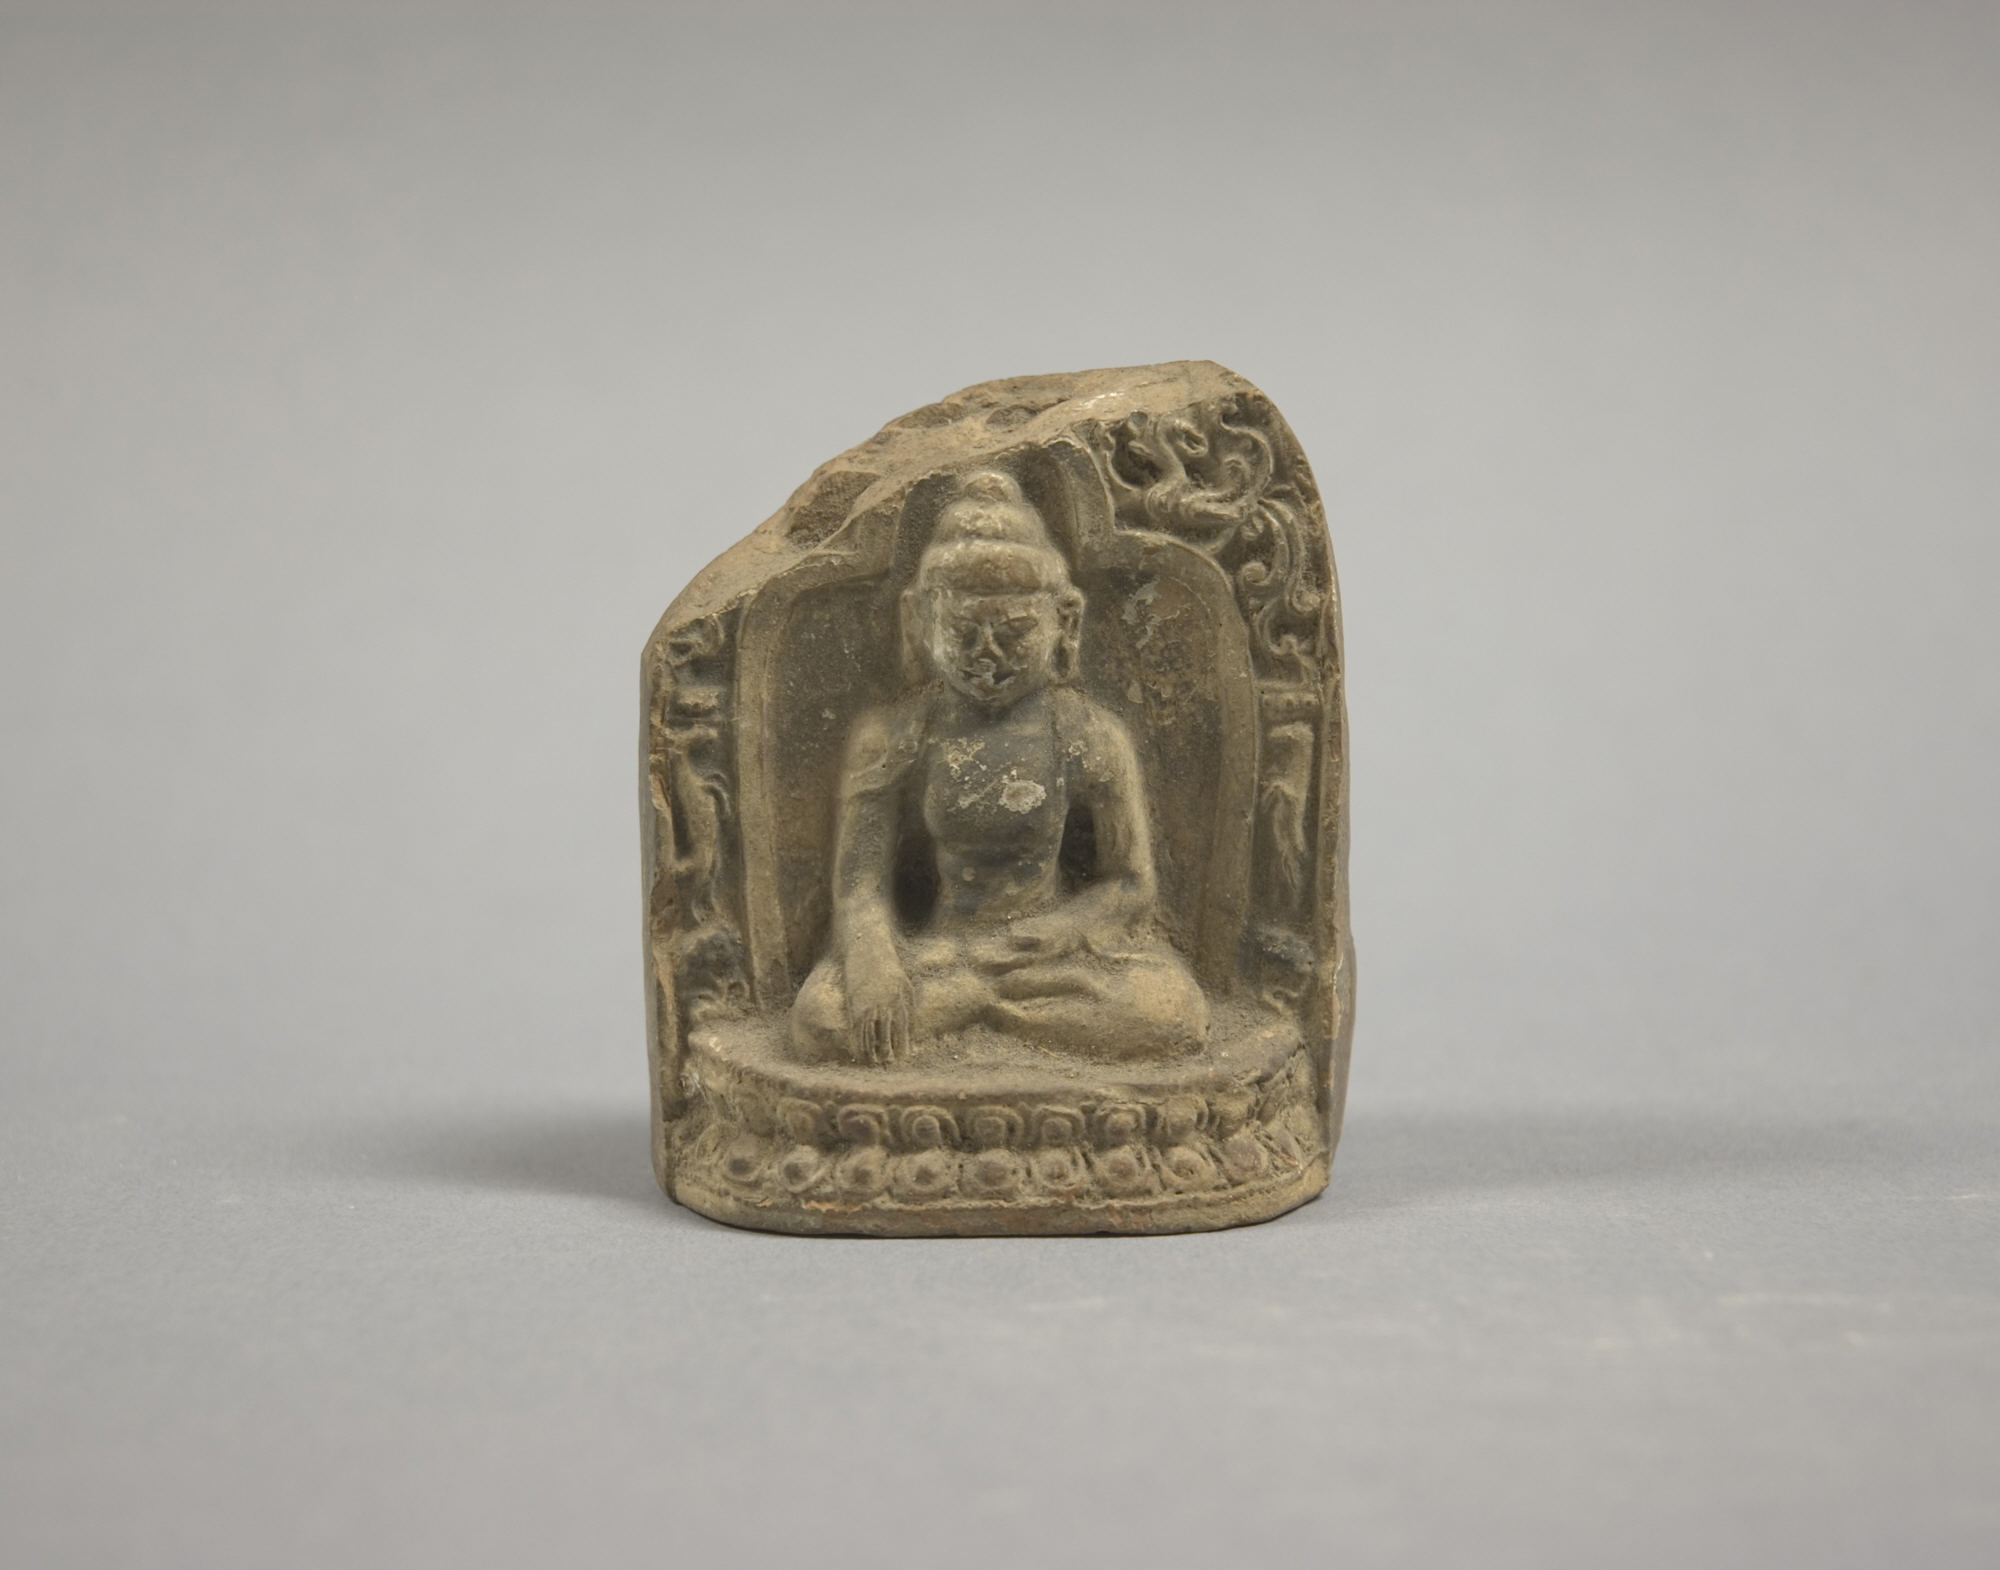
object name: figurine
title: Seated Buddha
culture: tibetan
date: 608-906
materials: pottery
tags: buddhism,buddha